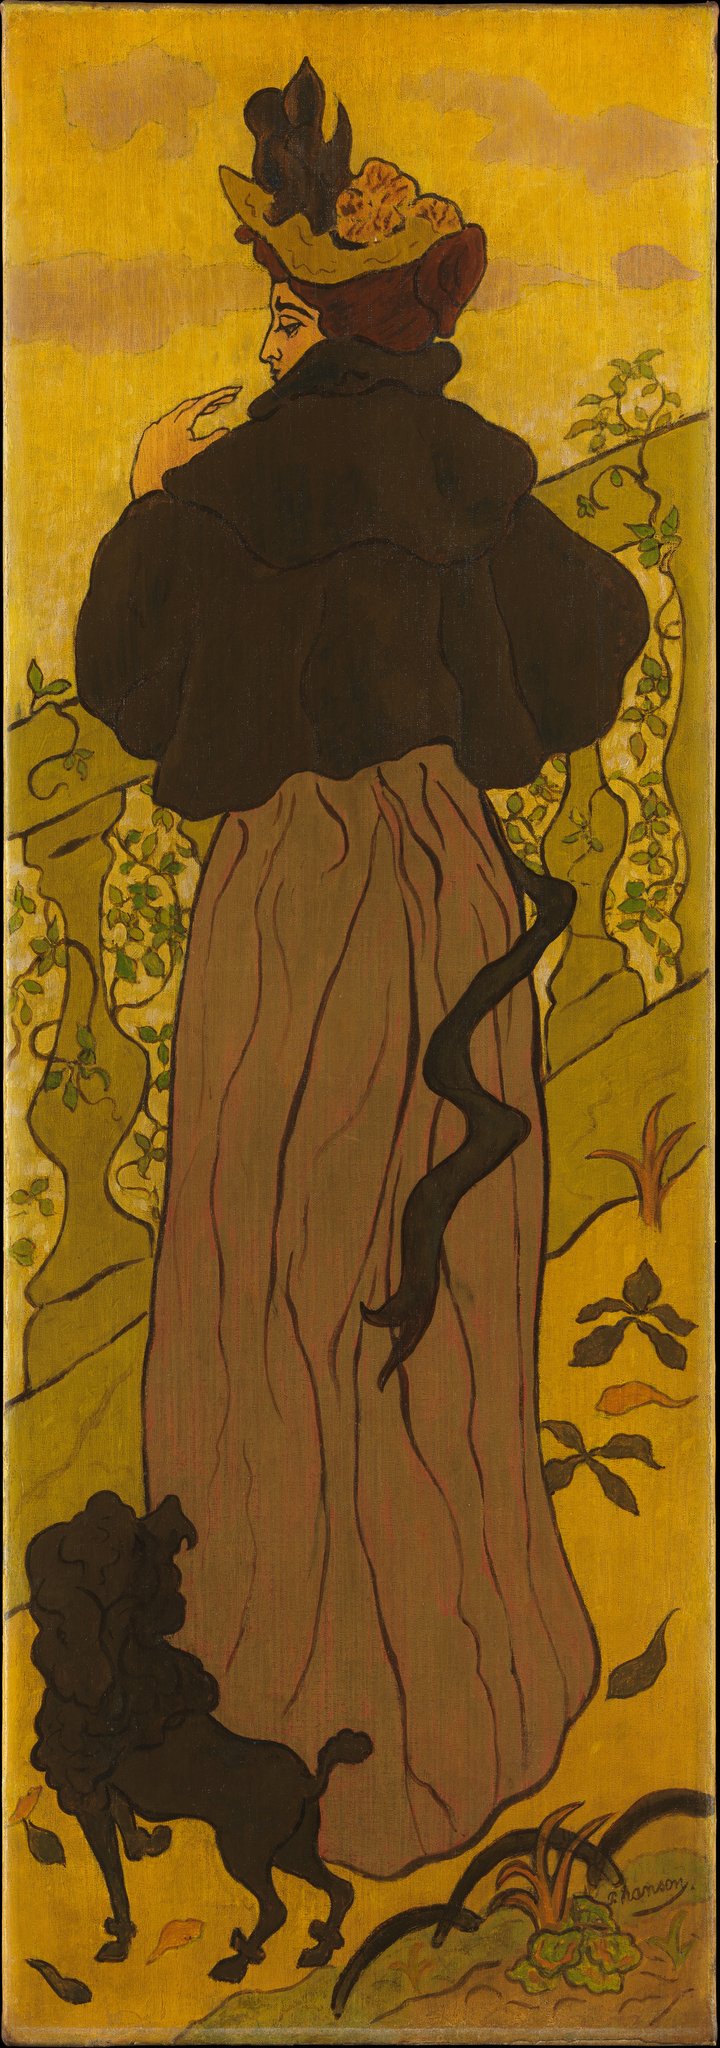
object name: painting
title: Woman Standing Beside a Balustrade with a Poodle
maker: paul ranson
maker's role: artist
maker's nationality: french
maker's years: 1864-1909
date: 1895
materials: oil, panel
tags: women,dogs